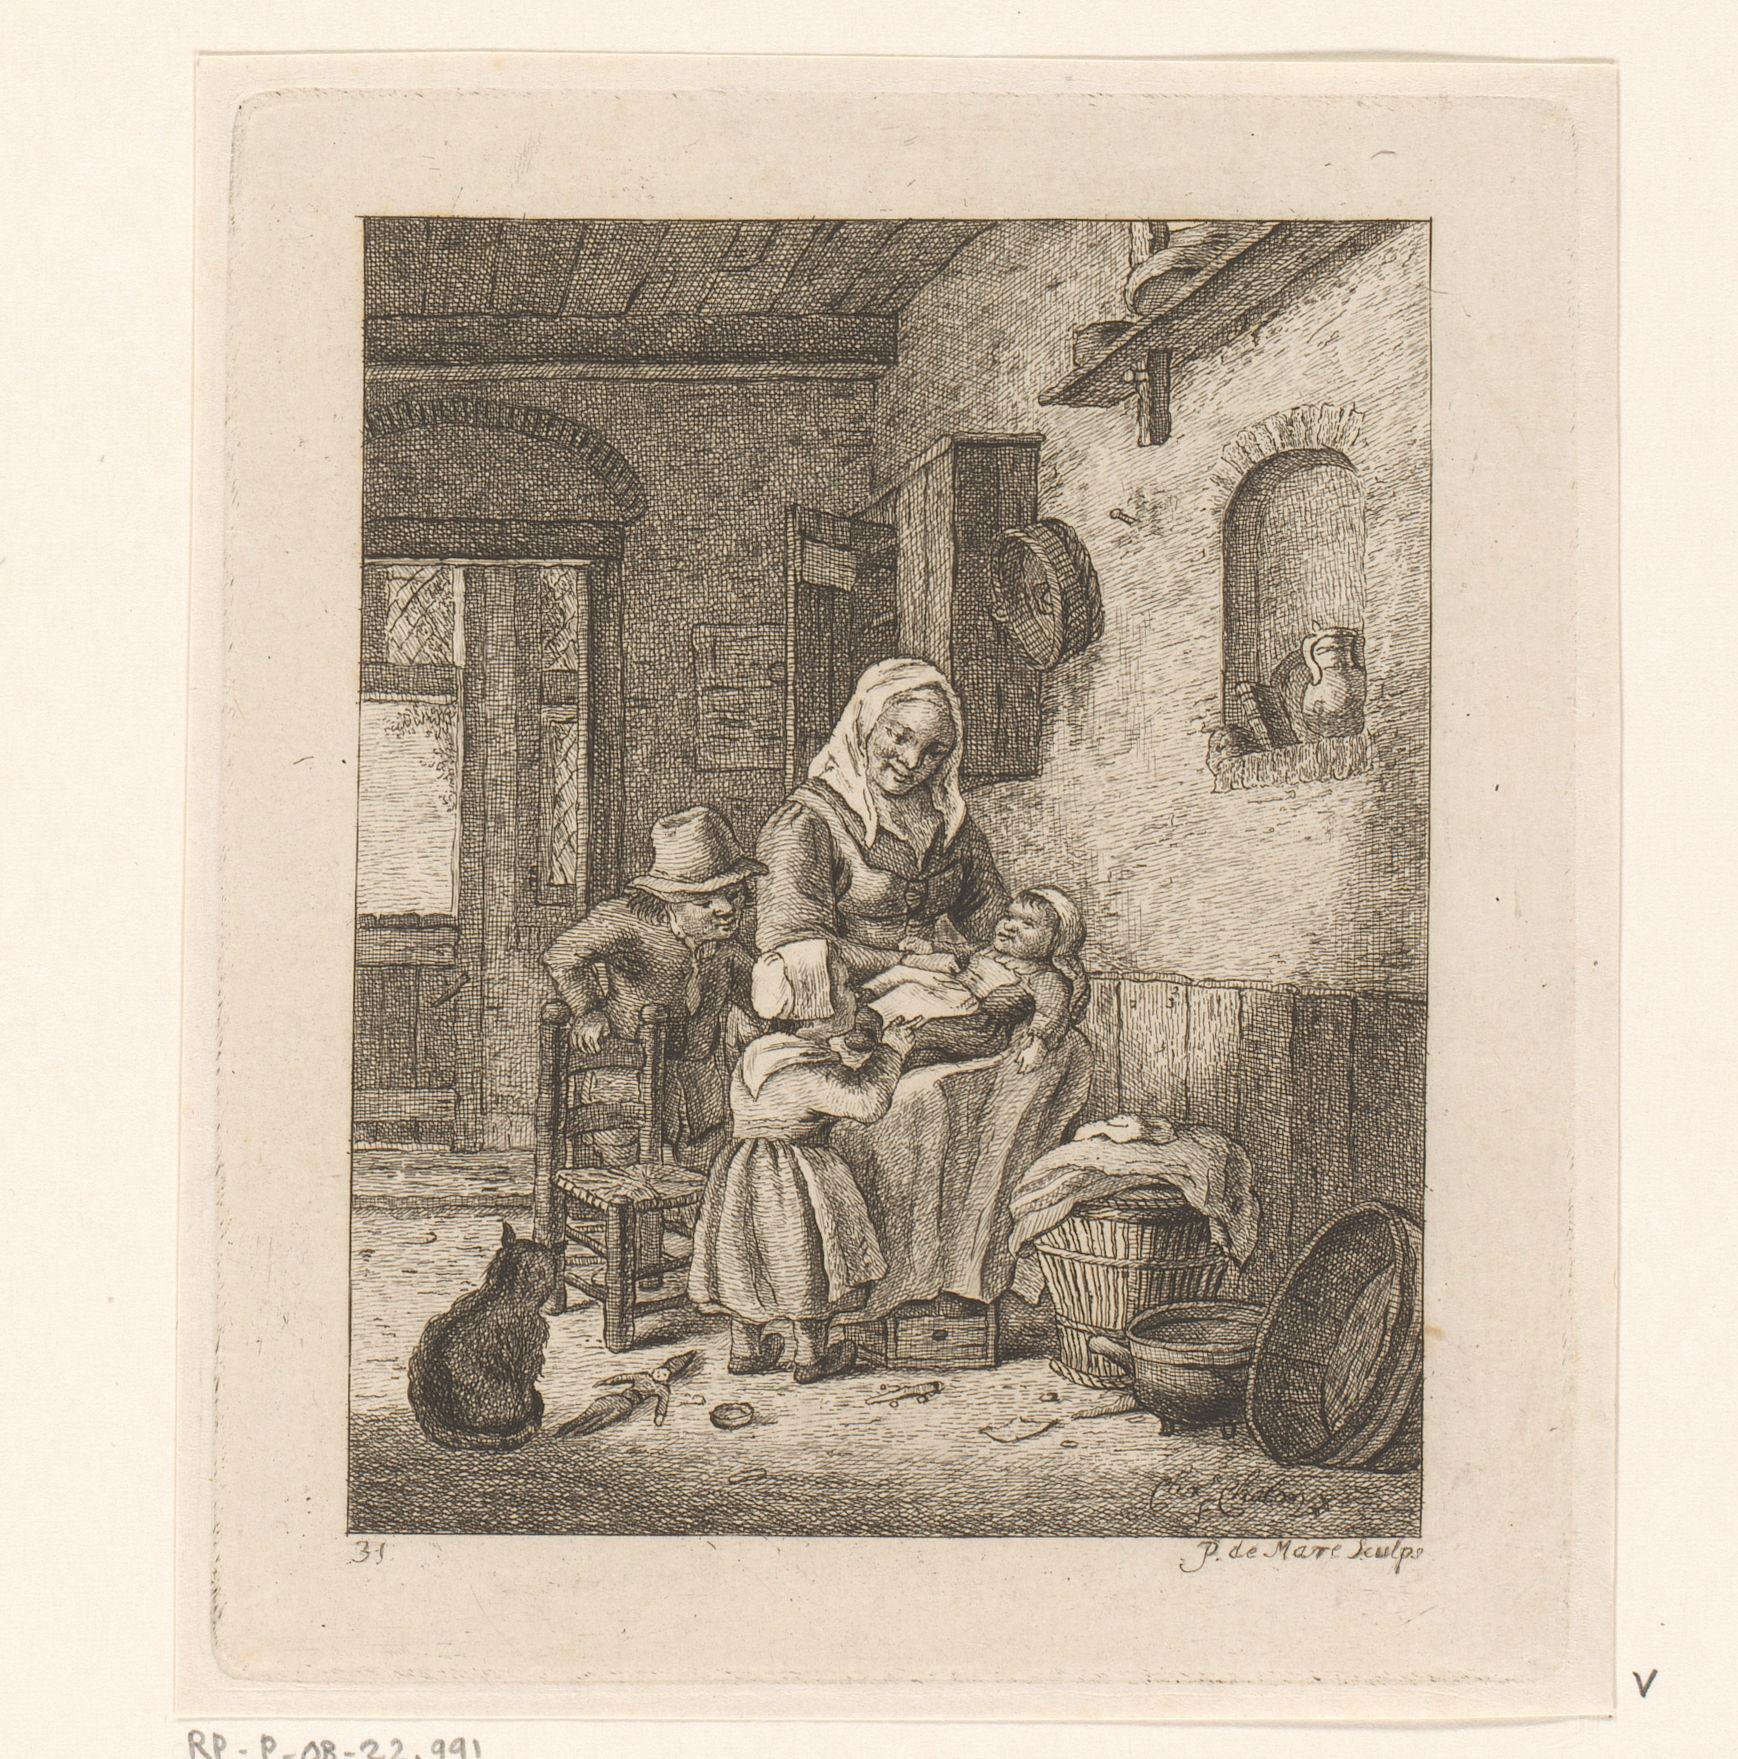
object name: print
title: Vrouw met kinderen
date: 1779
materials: paper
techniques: engraving, etching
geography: leiden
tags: mother and baby or young child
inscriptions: collector's mark: Lugt 240